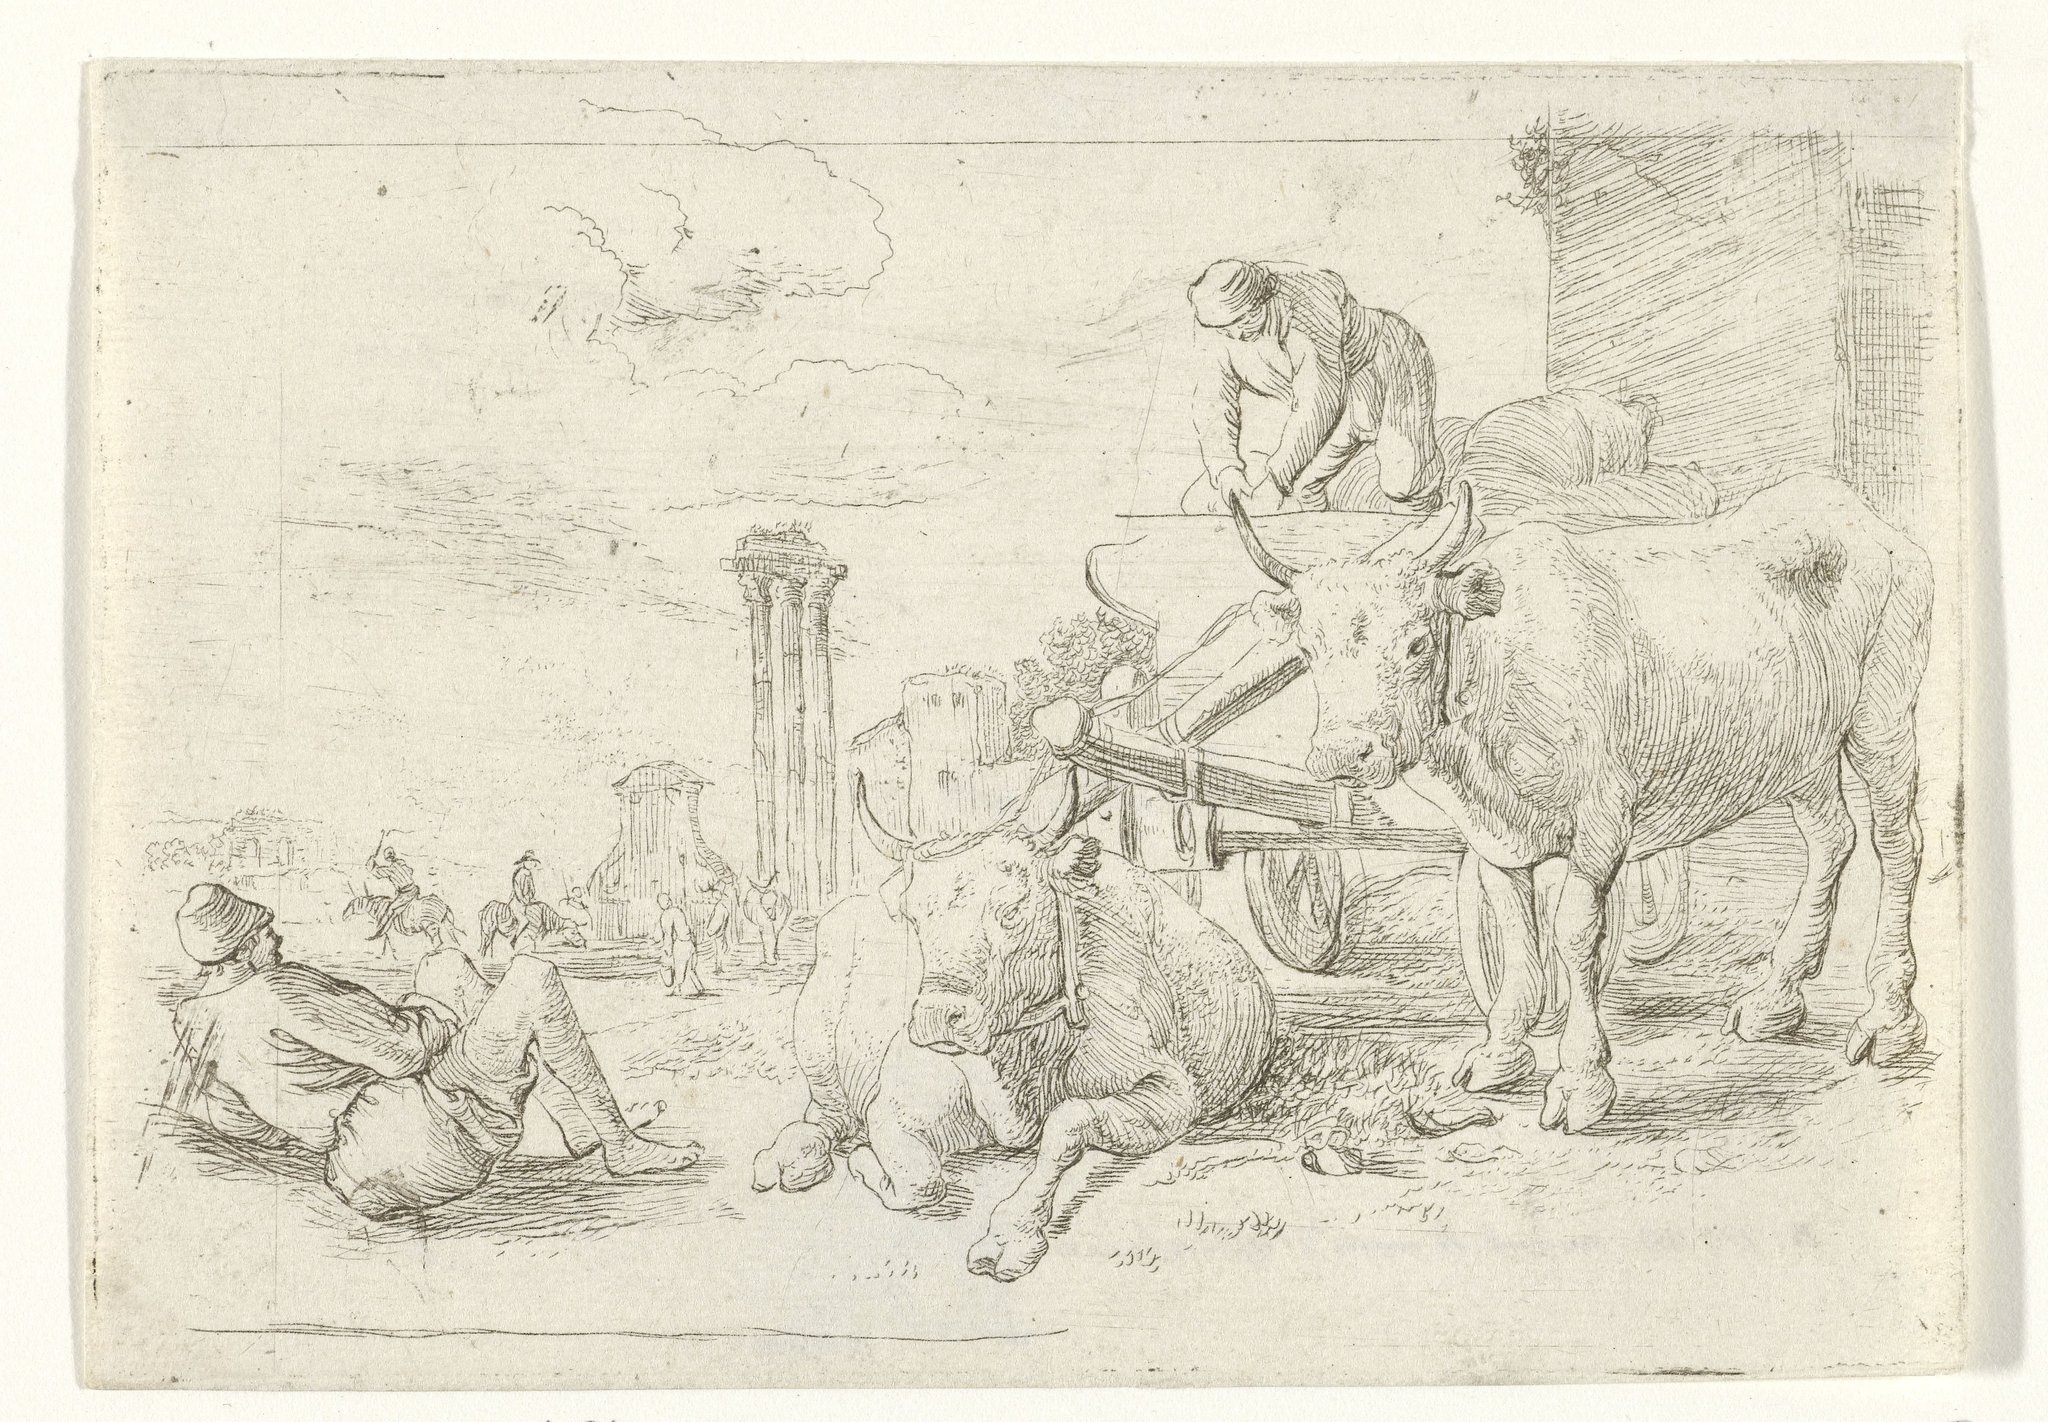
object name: print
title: Ossenkar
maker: jan van ossenbeeck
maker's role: print maker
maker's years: 1623-1674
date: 1647-1674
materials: paper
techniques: etching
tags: four-wheeled, animal-drawn vehicle, e.g.: cab, carriage, coach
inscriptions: collector's mark: ‘BK’, collector's mark: Lugt 2228, collector's mark: Lugt 270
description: Een liggende en een staande os voor een ossenkar. De kar wordt beladen door een boer. Op de achtergrond Romeinse ruïnes.